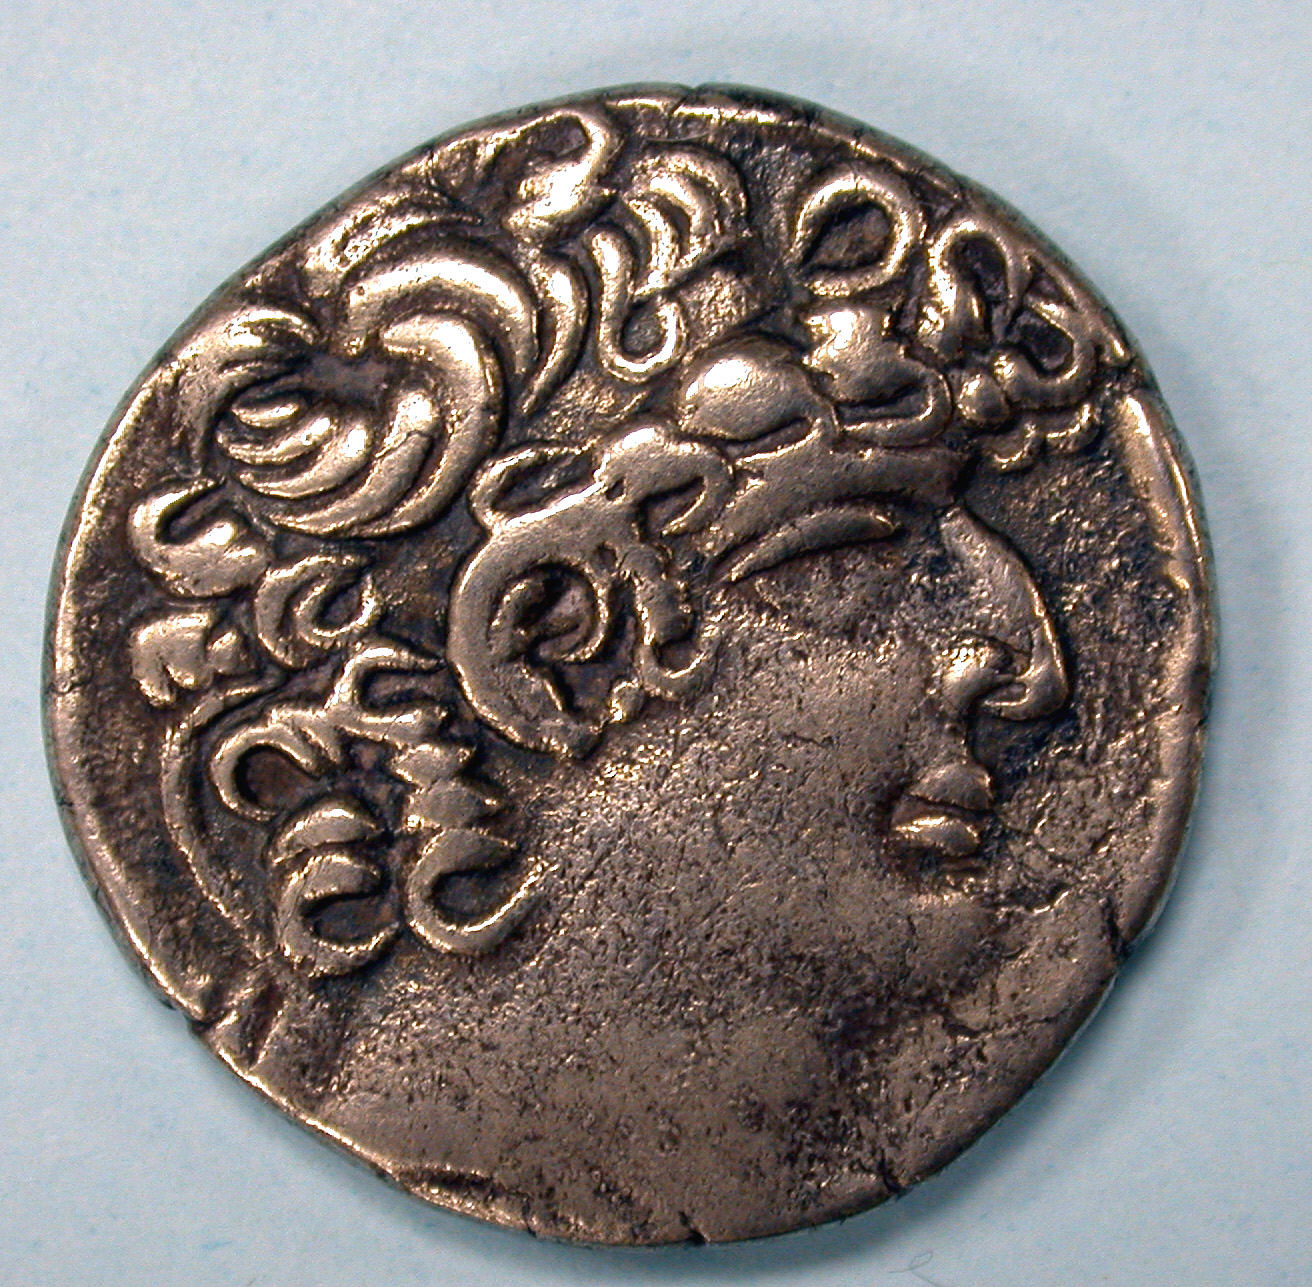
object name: tetradrachm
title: Silver Tetradrachm of Antiochus VIII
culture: greek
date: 121-97 BCE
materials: silver